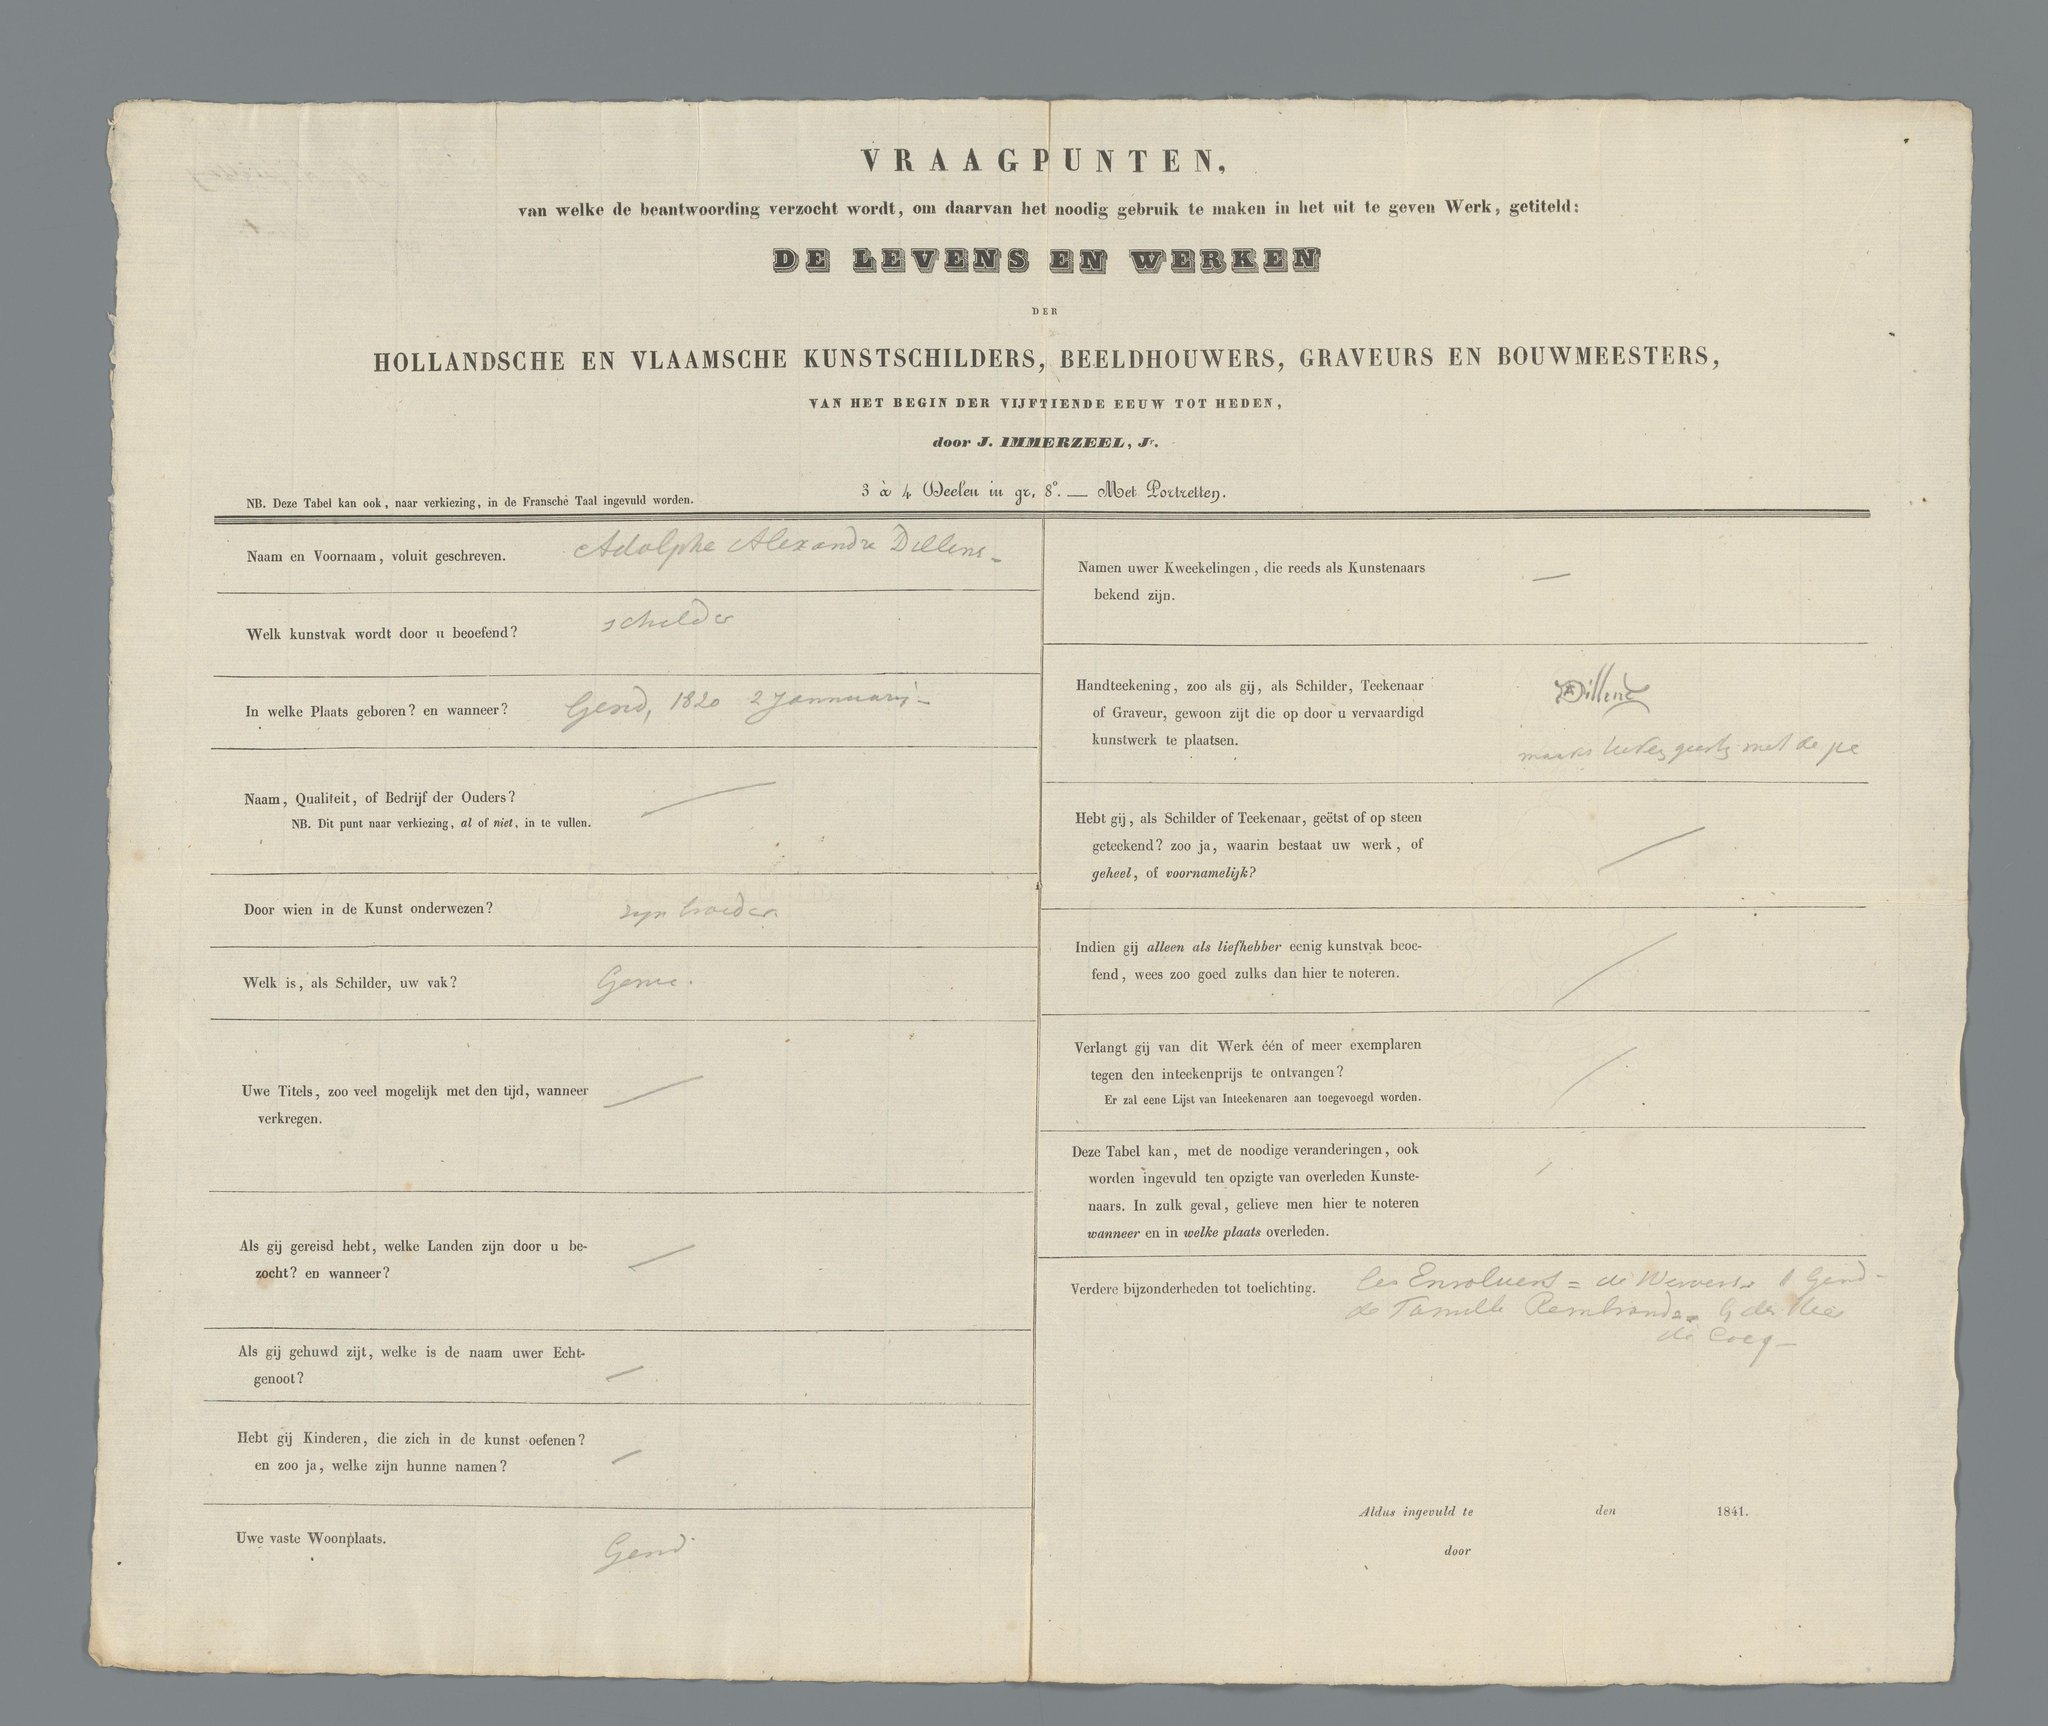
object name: questionnaire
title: Enquêteformulier ingevuld door Adolphe Alexandre Dillens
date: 1840-1843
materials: ink, paper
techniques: pen, printing, writing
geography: ghent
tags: ghent, brussels, painter, print maker, draughtsman, adolphe alexandre dillens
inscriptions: inscription: ‘Vraagpunten,/ van welke de beantwoording verzocht wordt, om daarvan het noodig gebruik te maken in het uit te geven Werk, getiteld: De levens en werken/ der Hollandsche en Vlaamsche kunstschilders, beeldhouwers,/ graveurs en bouwmeesters, van het begin der vijftiende eeuw tot heden/ door J. Immerzeel, Jr.’, watermark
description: Geplaatst in: Immerzeel, J. Jr., De levens en werken der Hollandsche en Vlaamsche kunstschilders, beeldhouwers, graveurs en bouwmeesters, van het begin der vijftiende eeuw tot heden, Amsterdam: J.C. van Kesteren, 1842-1843.